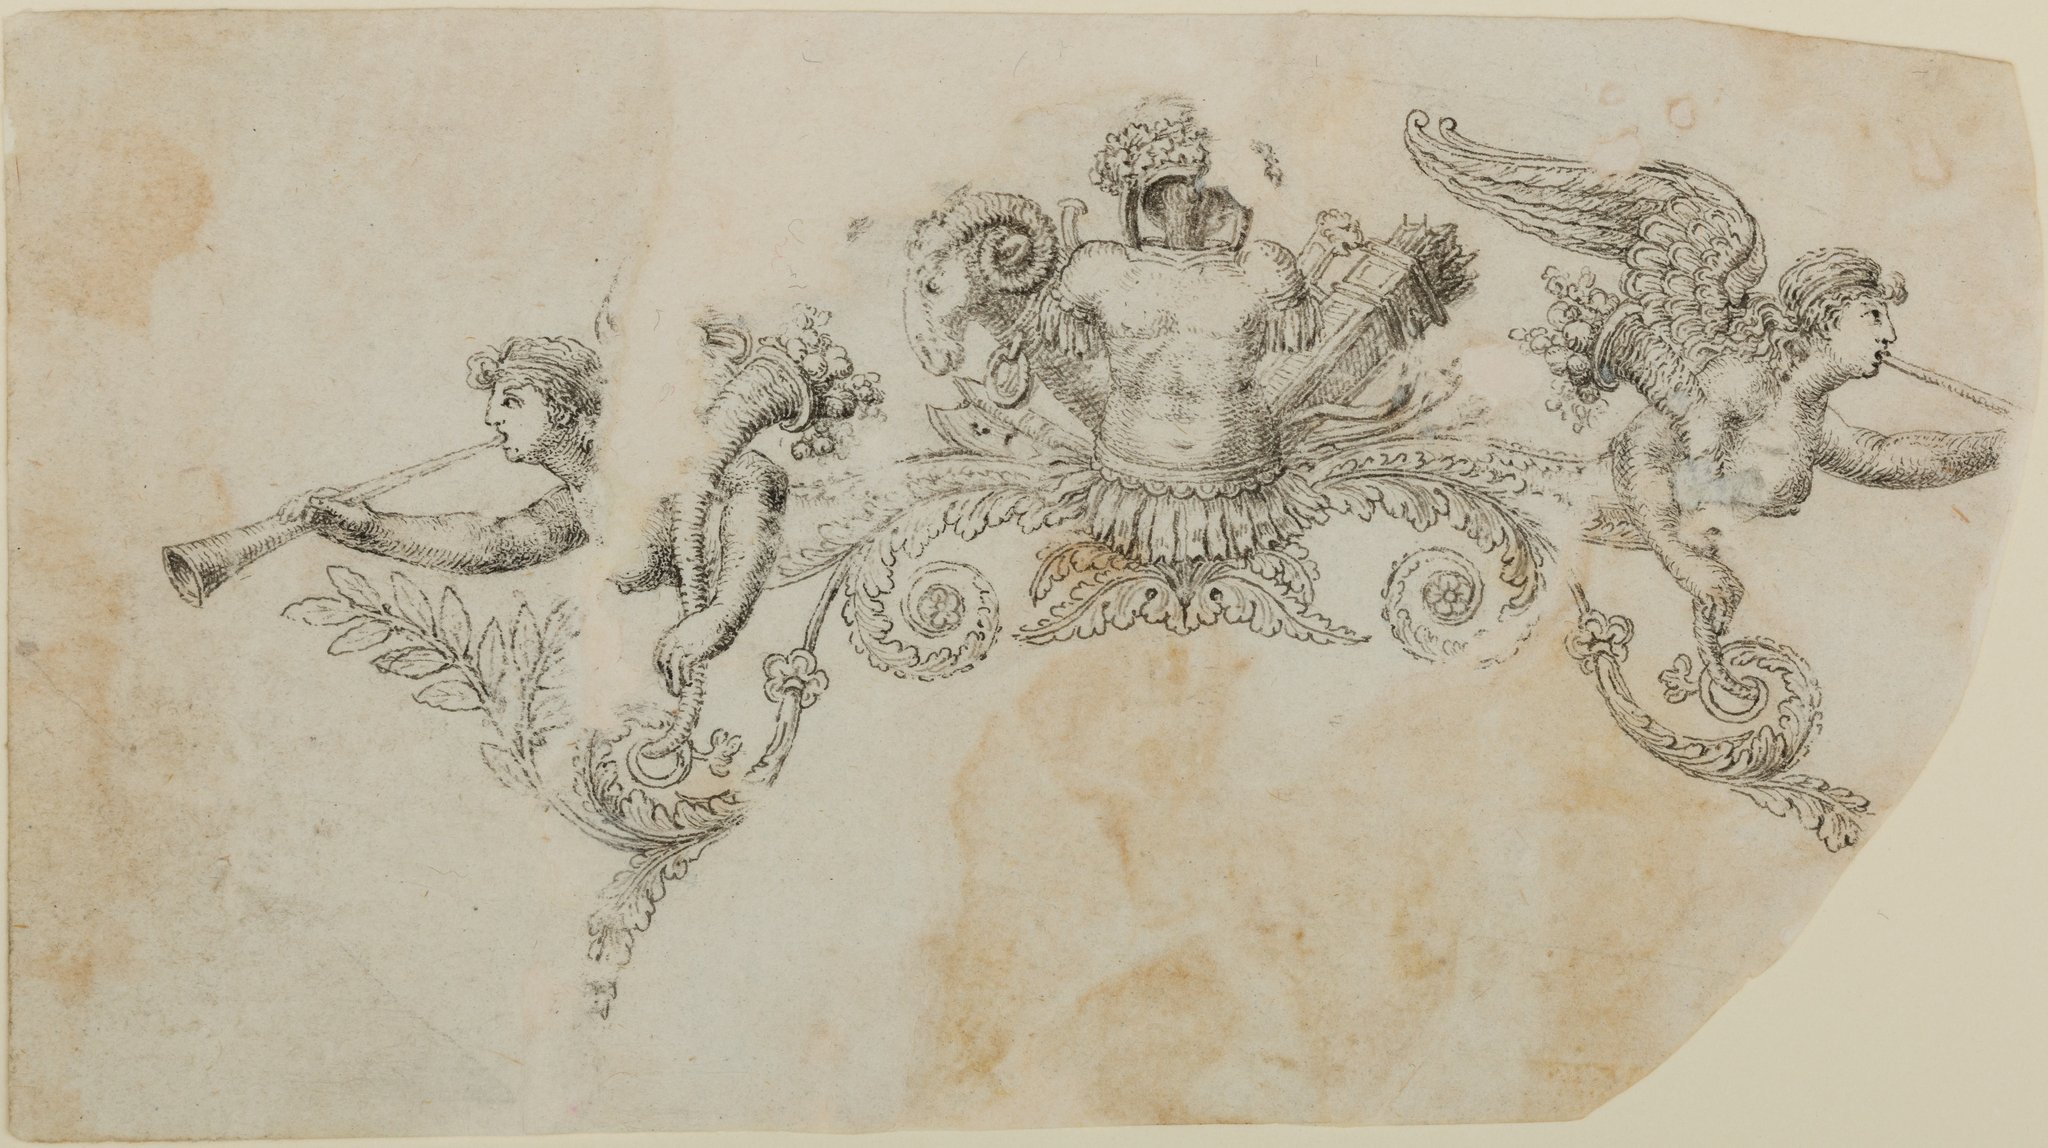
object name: drawing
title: Design for the Decoration of Firearms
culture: french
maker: nicolas noël boutet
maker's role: designer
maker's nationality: french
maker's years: 1761-1833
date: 1797-1805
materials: ink, paper, pencil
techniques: wash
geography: france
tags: ornament